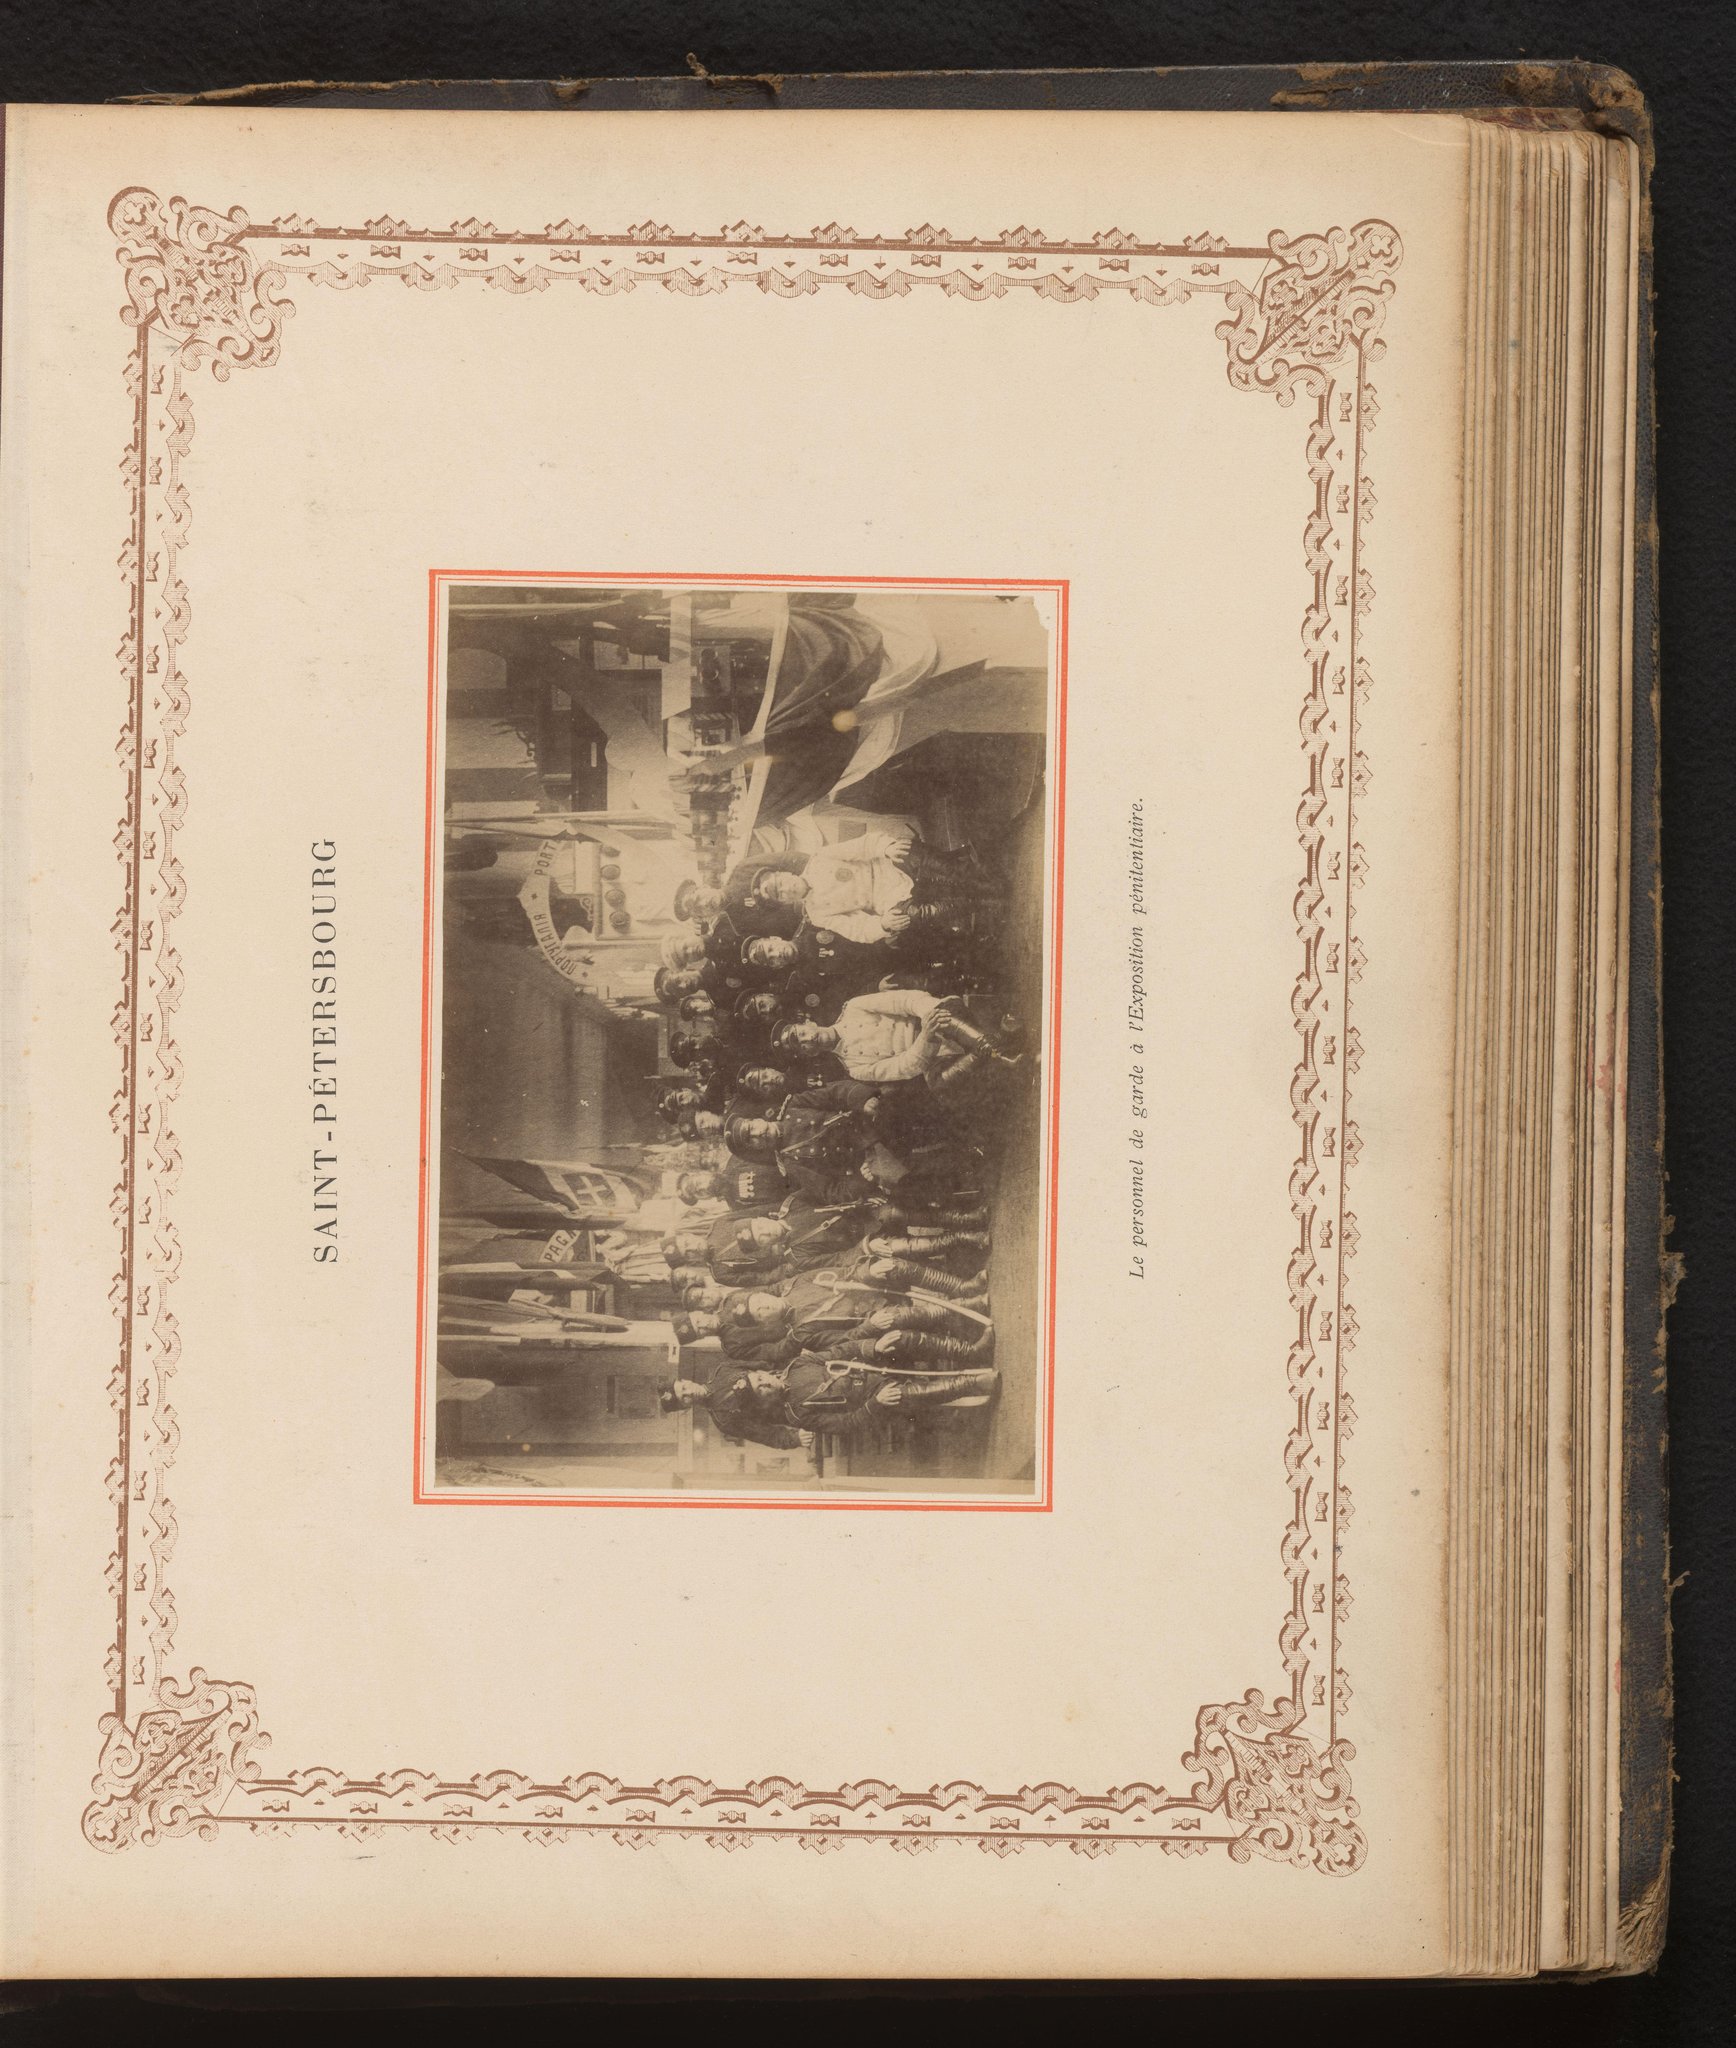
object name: photograph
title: Saint-Pétersbourg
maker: Anonymous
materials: photographic support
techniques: albumen print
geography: sint-petersburg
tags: guard duty, keeping sentry, anonymous historical persons portrayed in a group, in a group-portrait